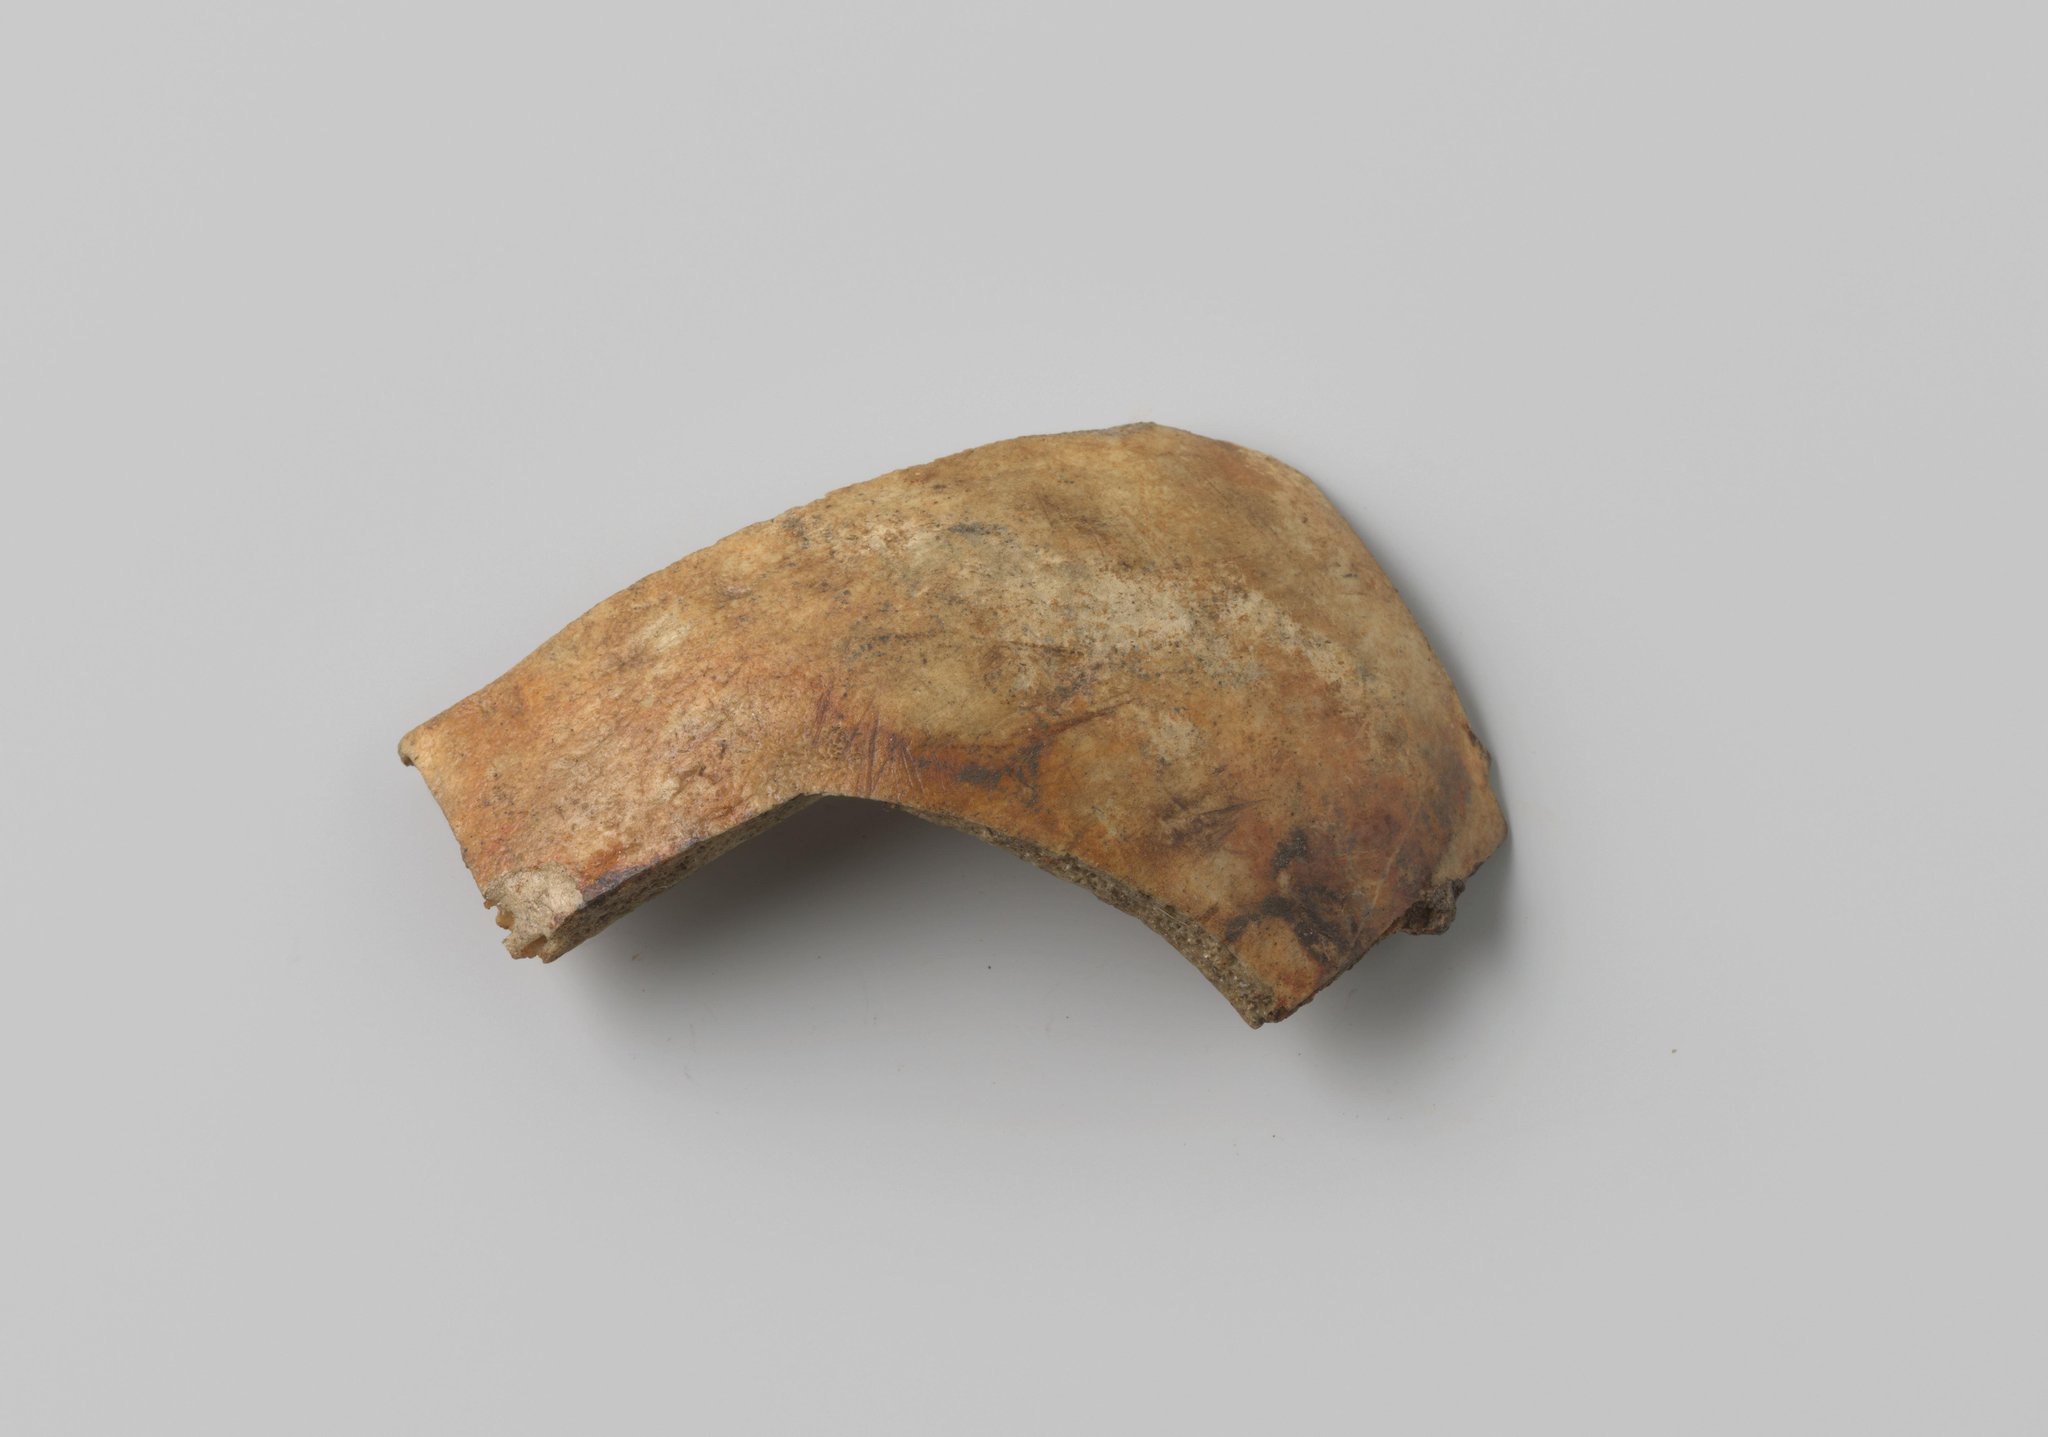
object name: bone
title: Fragment menselijke schedel uit het wrak van de Oost-Indiëvaarder Hollandia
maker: niet van toepassing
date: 1700-1743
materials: bone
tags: verenigde oostindische compagnie, hollandia (schip), annet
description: Human remains: bones; fragm of parietale (part of skull).